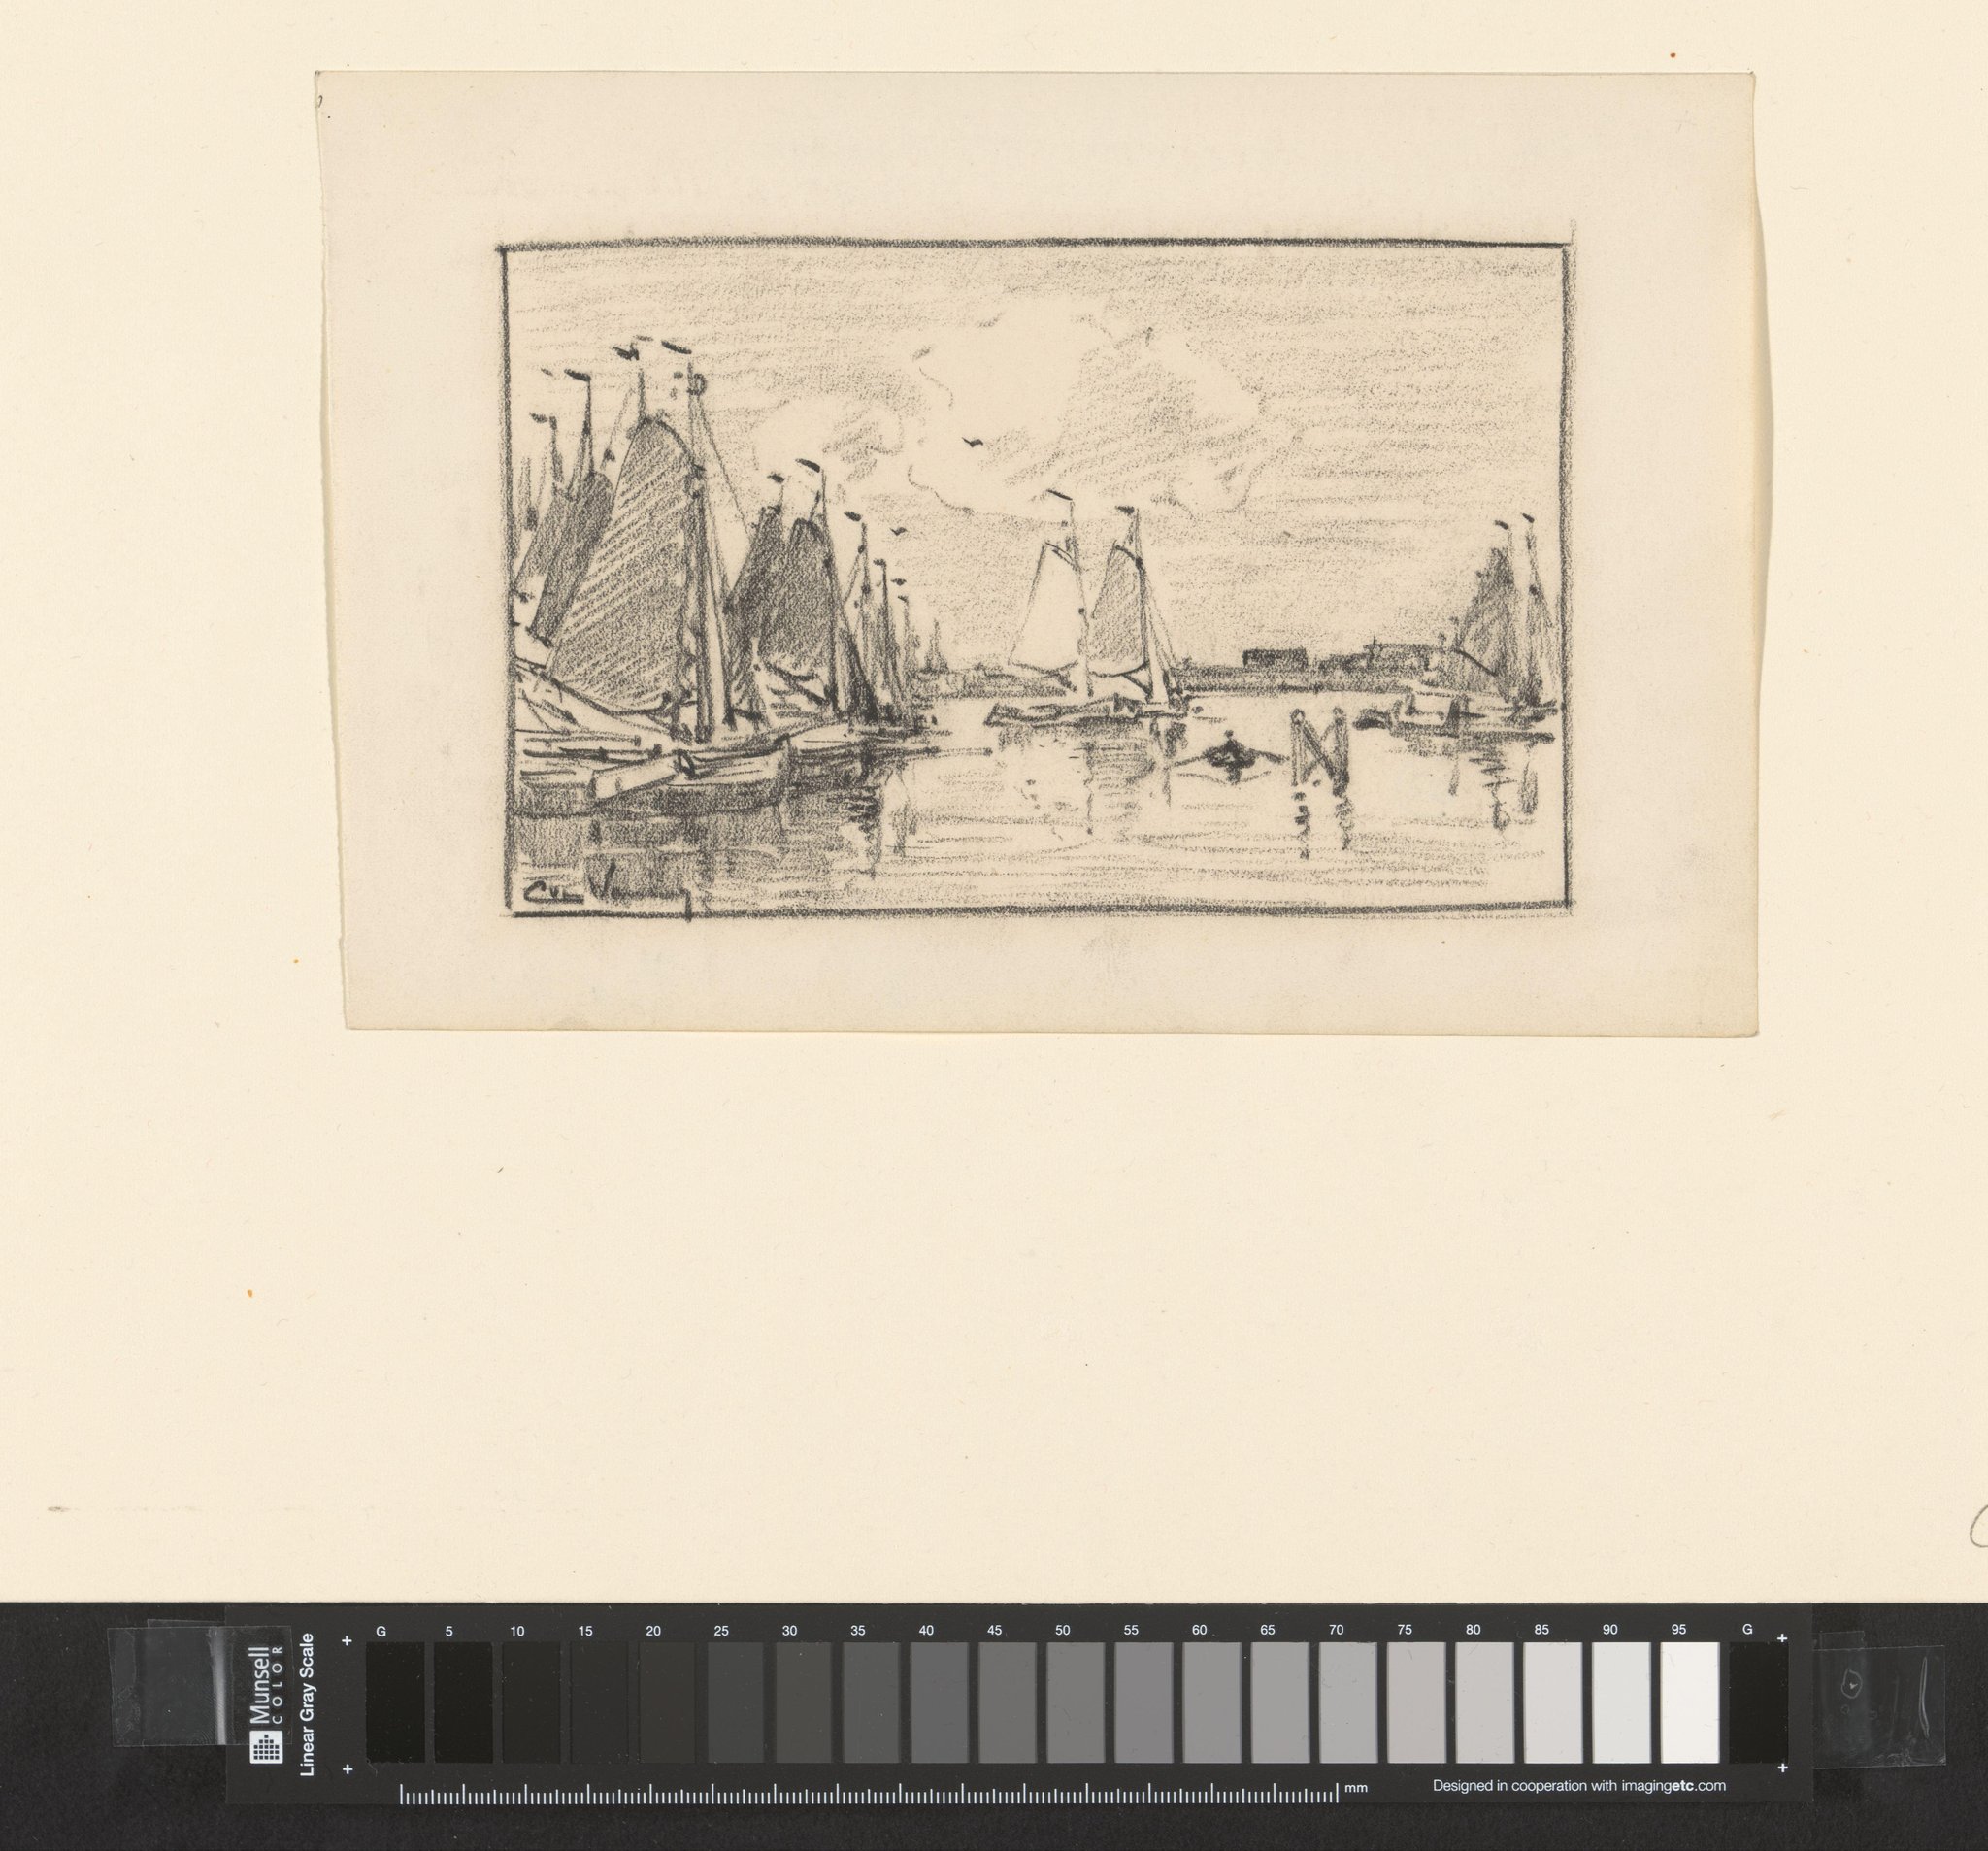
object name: drawing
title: Schepen in een haven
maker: kees van waning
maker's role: draughtsman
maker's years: 1861-1929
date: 1871-1929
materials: chalk, paper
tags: harbour, sailing-ship, sailing-boat